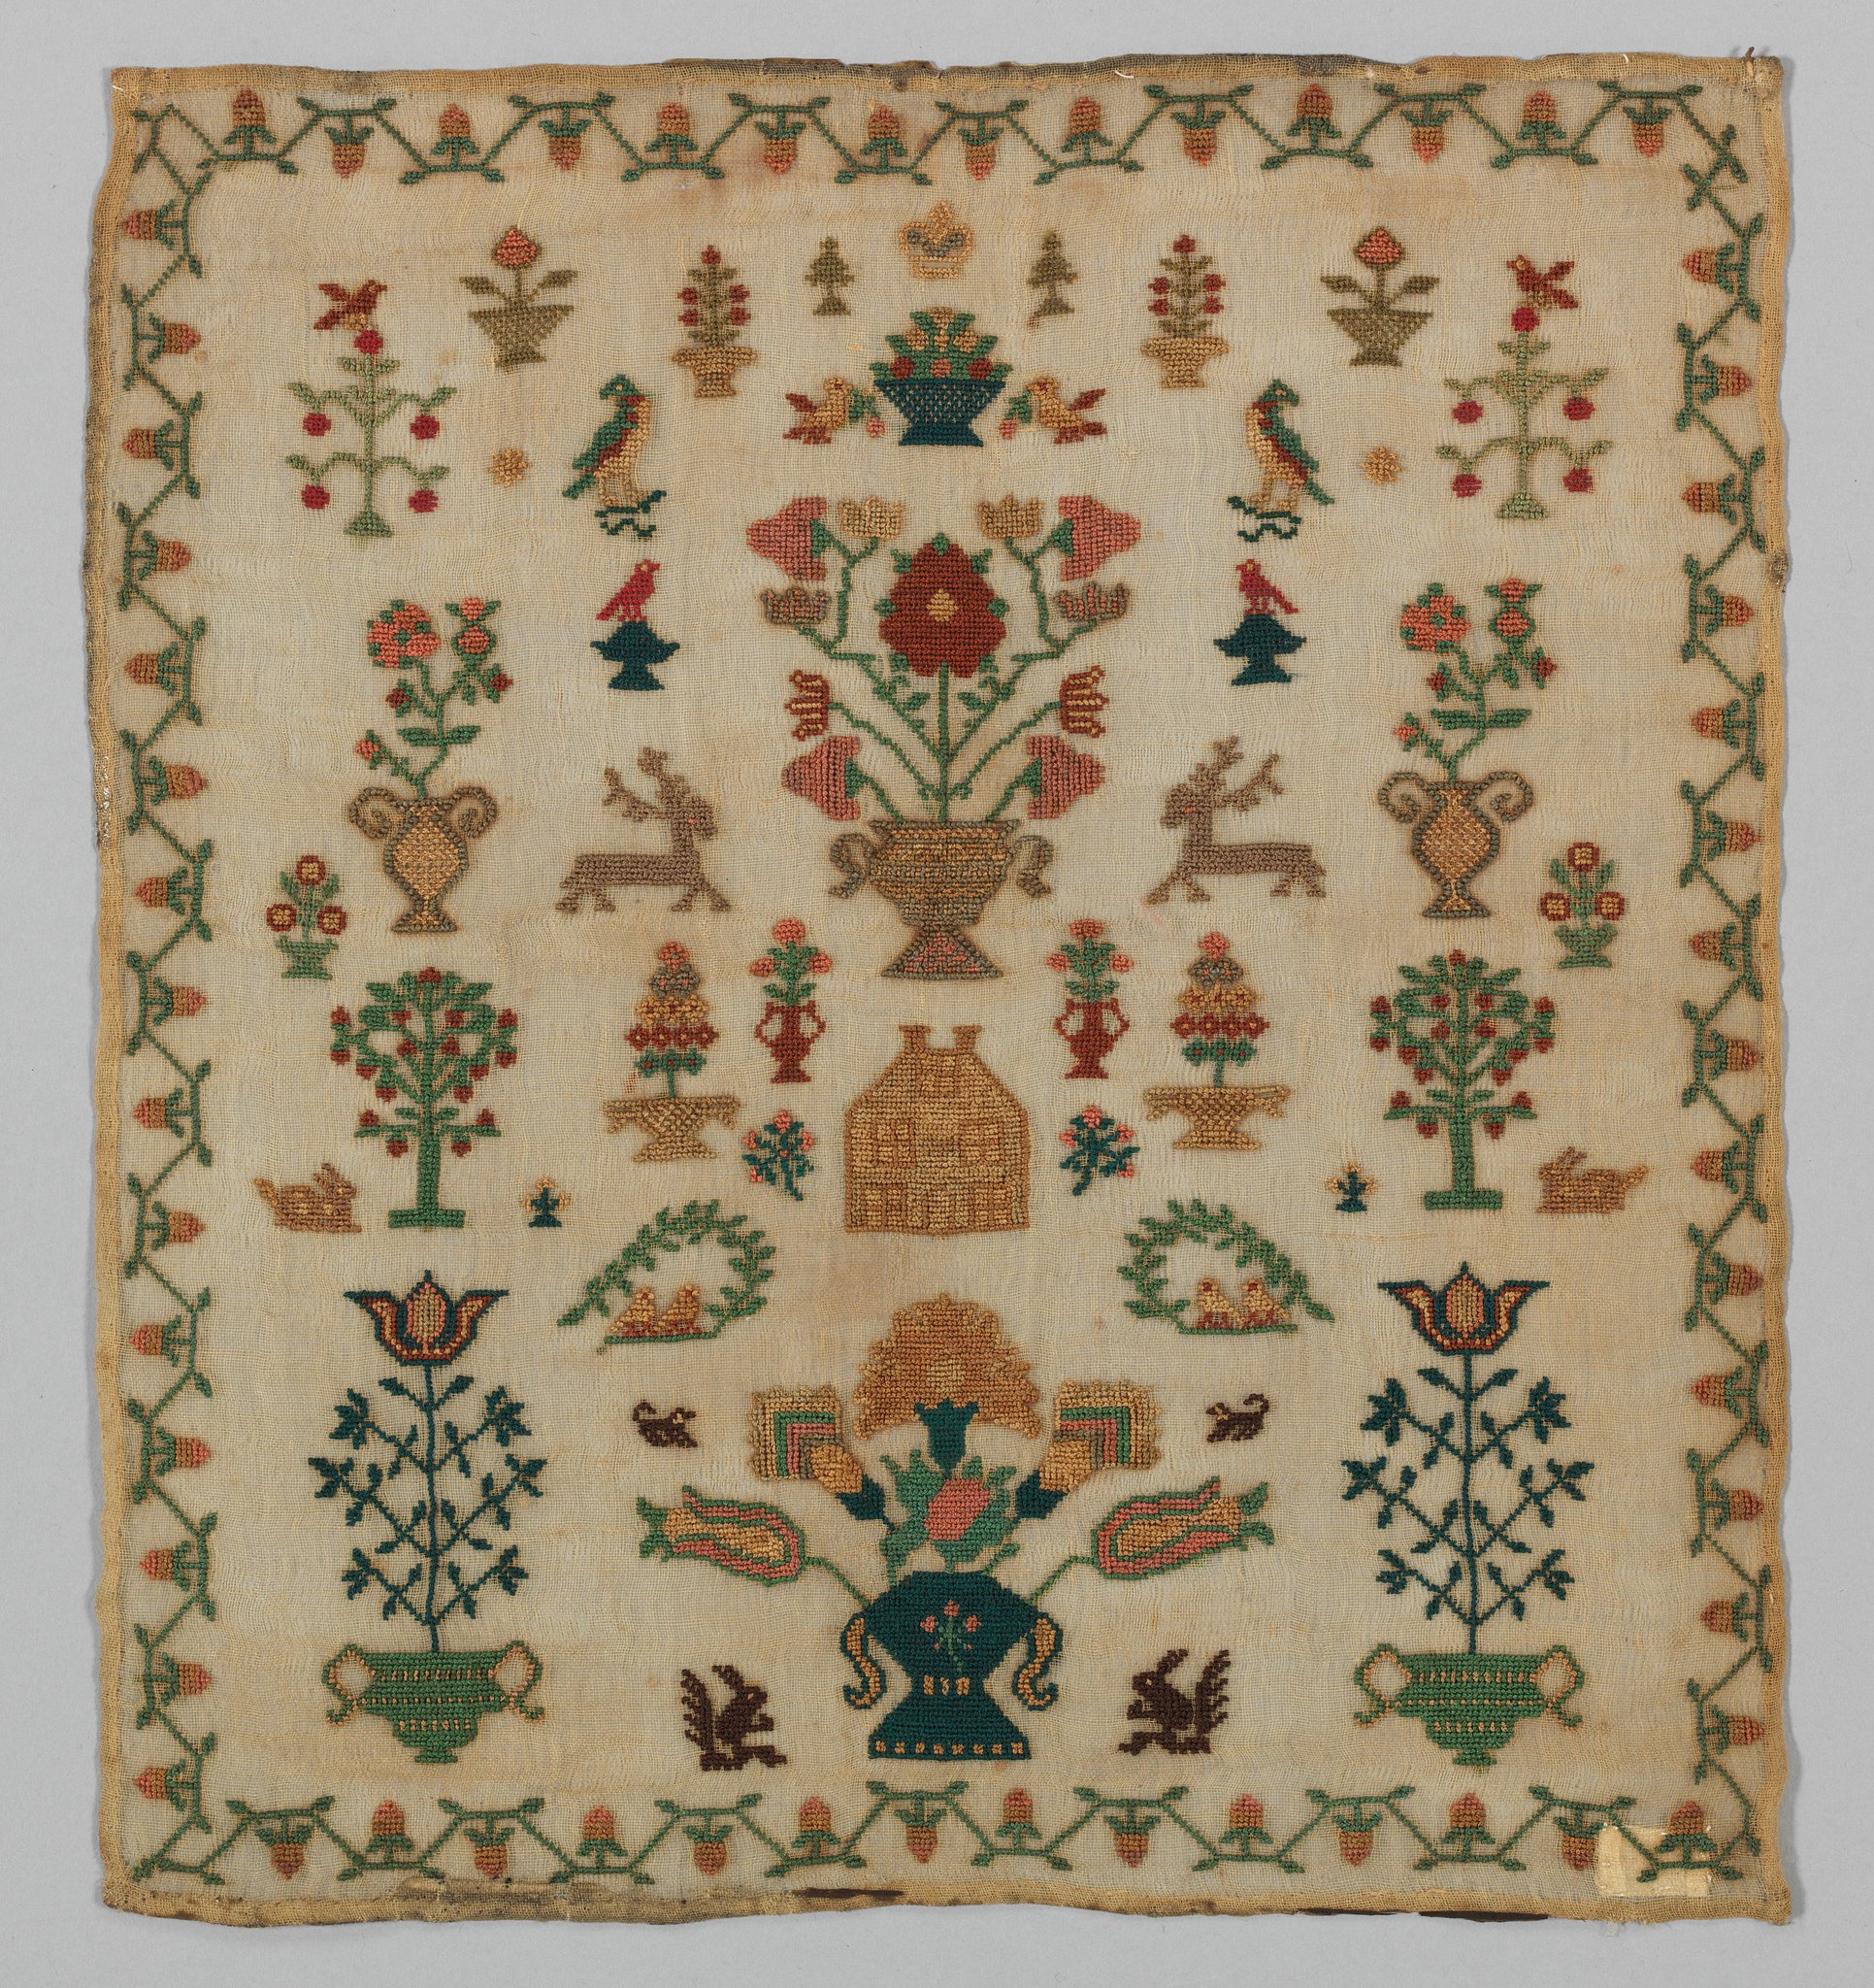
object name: sampler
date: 1825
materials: silk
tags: birds,deer,flowers